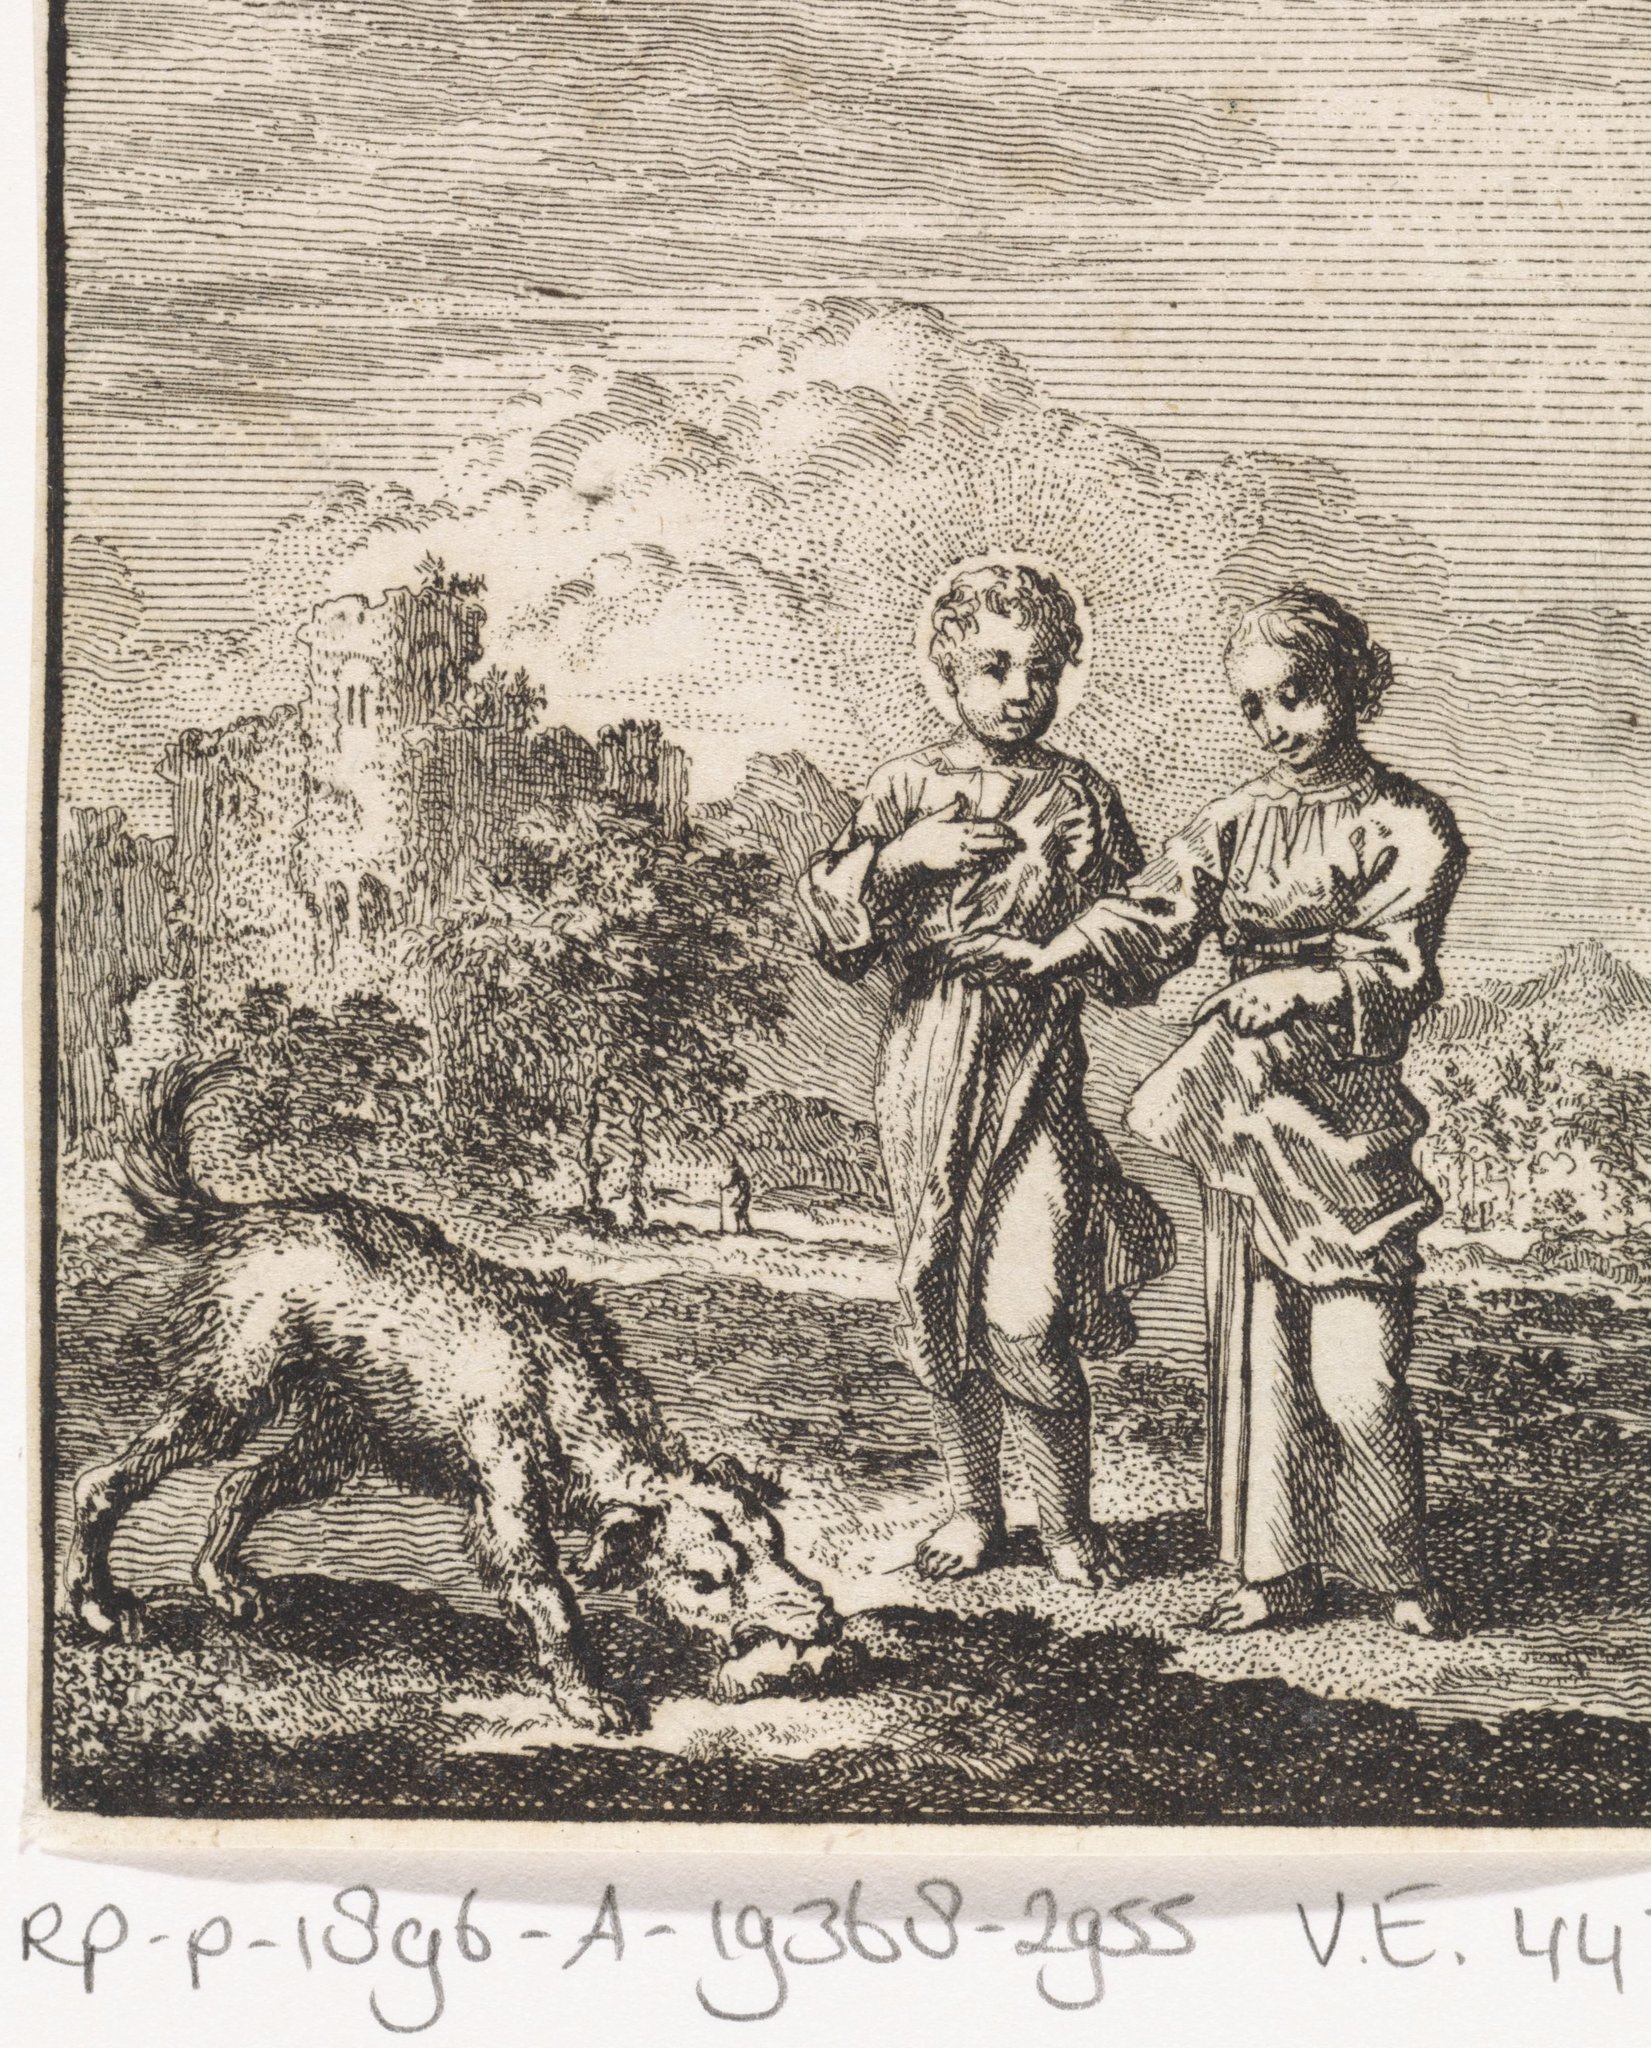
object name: print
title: Christus en de gepersonifieerde ziel aanschouwen een hond die op een steen bijt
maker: jan luyken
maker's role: draughtsman, print maker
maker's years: 1649-1712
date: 1714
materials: paper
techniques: etching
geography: amsterdam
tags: the soul, christ and the soul, dog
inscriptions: collector's mark: Lugt 2228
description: Proefdruk van illustratie uit: Luyken, Jan. Jezus en de Ziel, 3 delen. Amsterdam: Wed. Pieter Arentsz II en Cornelis van der Sys, 1714, dl. III, p. 147.